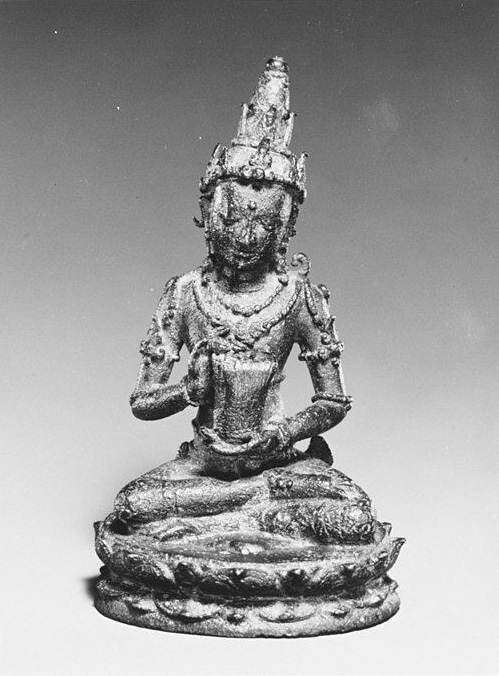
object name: figurine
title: Seated Male Deity Holding a Cuirass (Chest Armour)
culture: indonesian, java, ngandjuk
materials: bronze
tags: deities